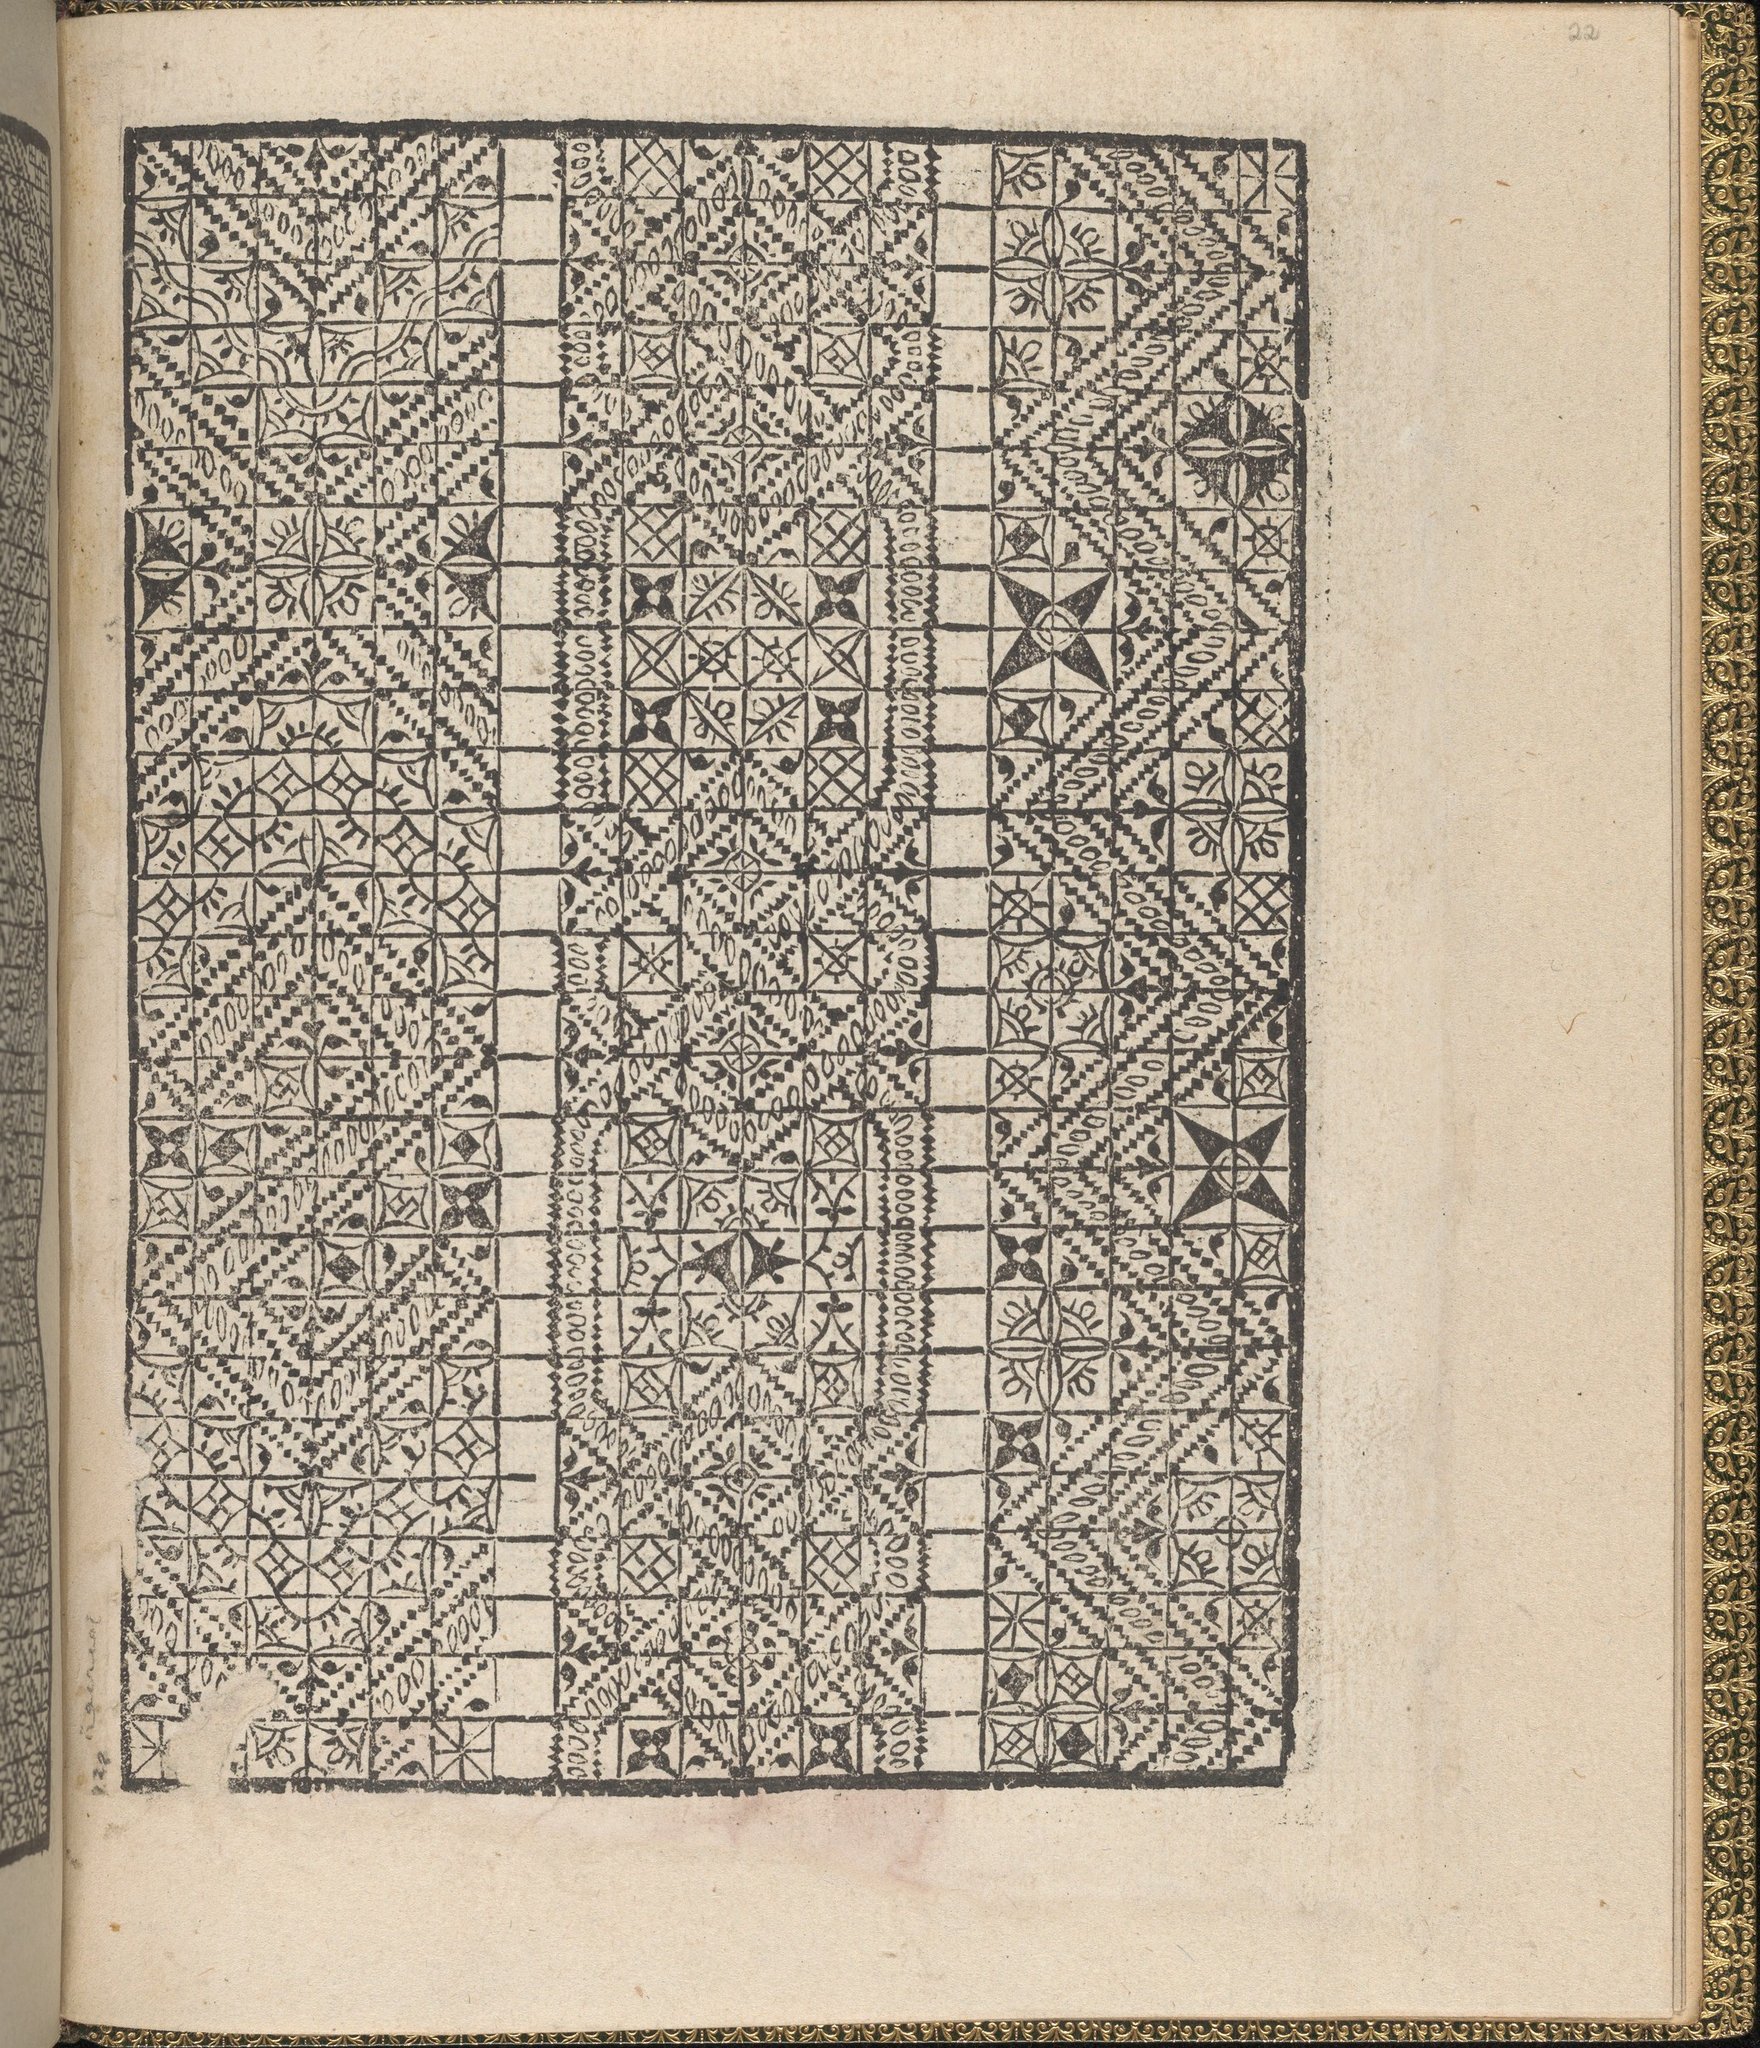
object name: book print ornament architecture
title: Giardineto novo di punti tagliati et gropposi per exercitio & ornamento delle donne (Venice 1554), page 22 (recto)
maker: matteo pagano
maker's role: publisher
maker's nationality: italian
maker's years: 1515-1588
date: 1554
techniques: woodcut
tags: ornament